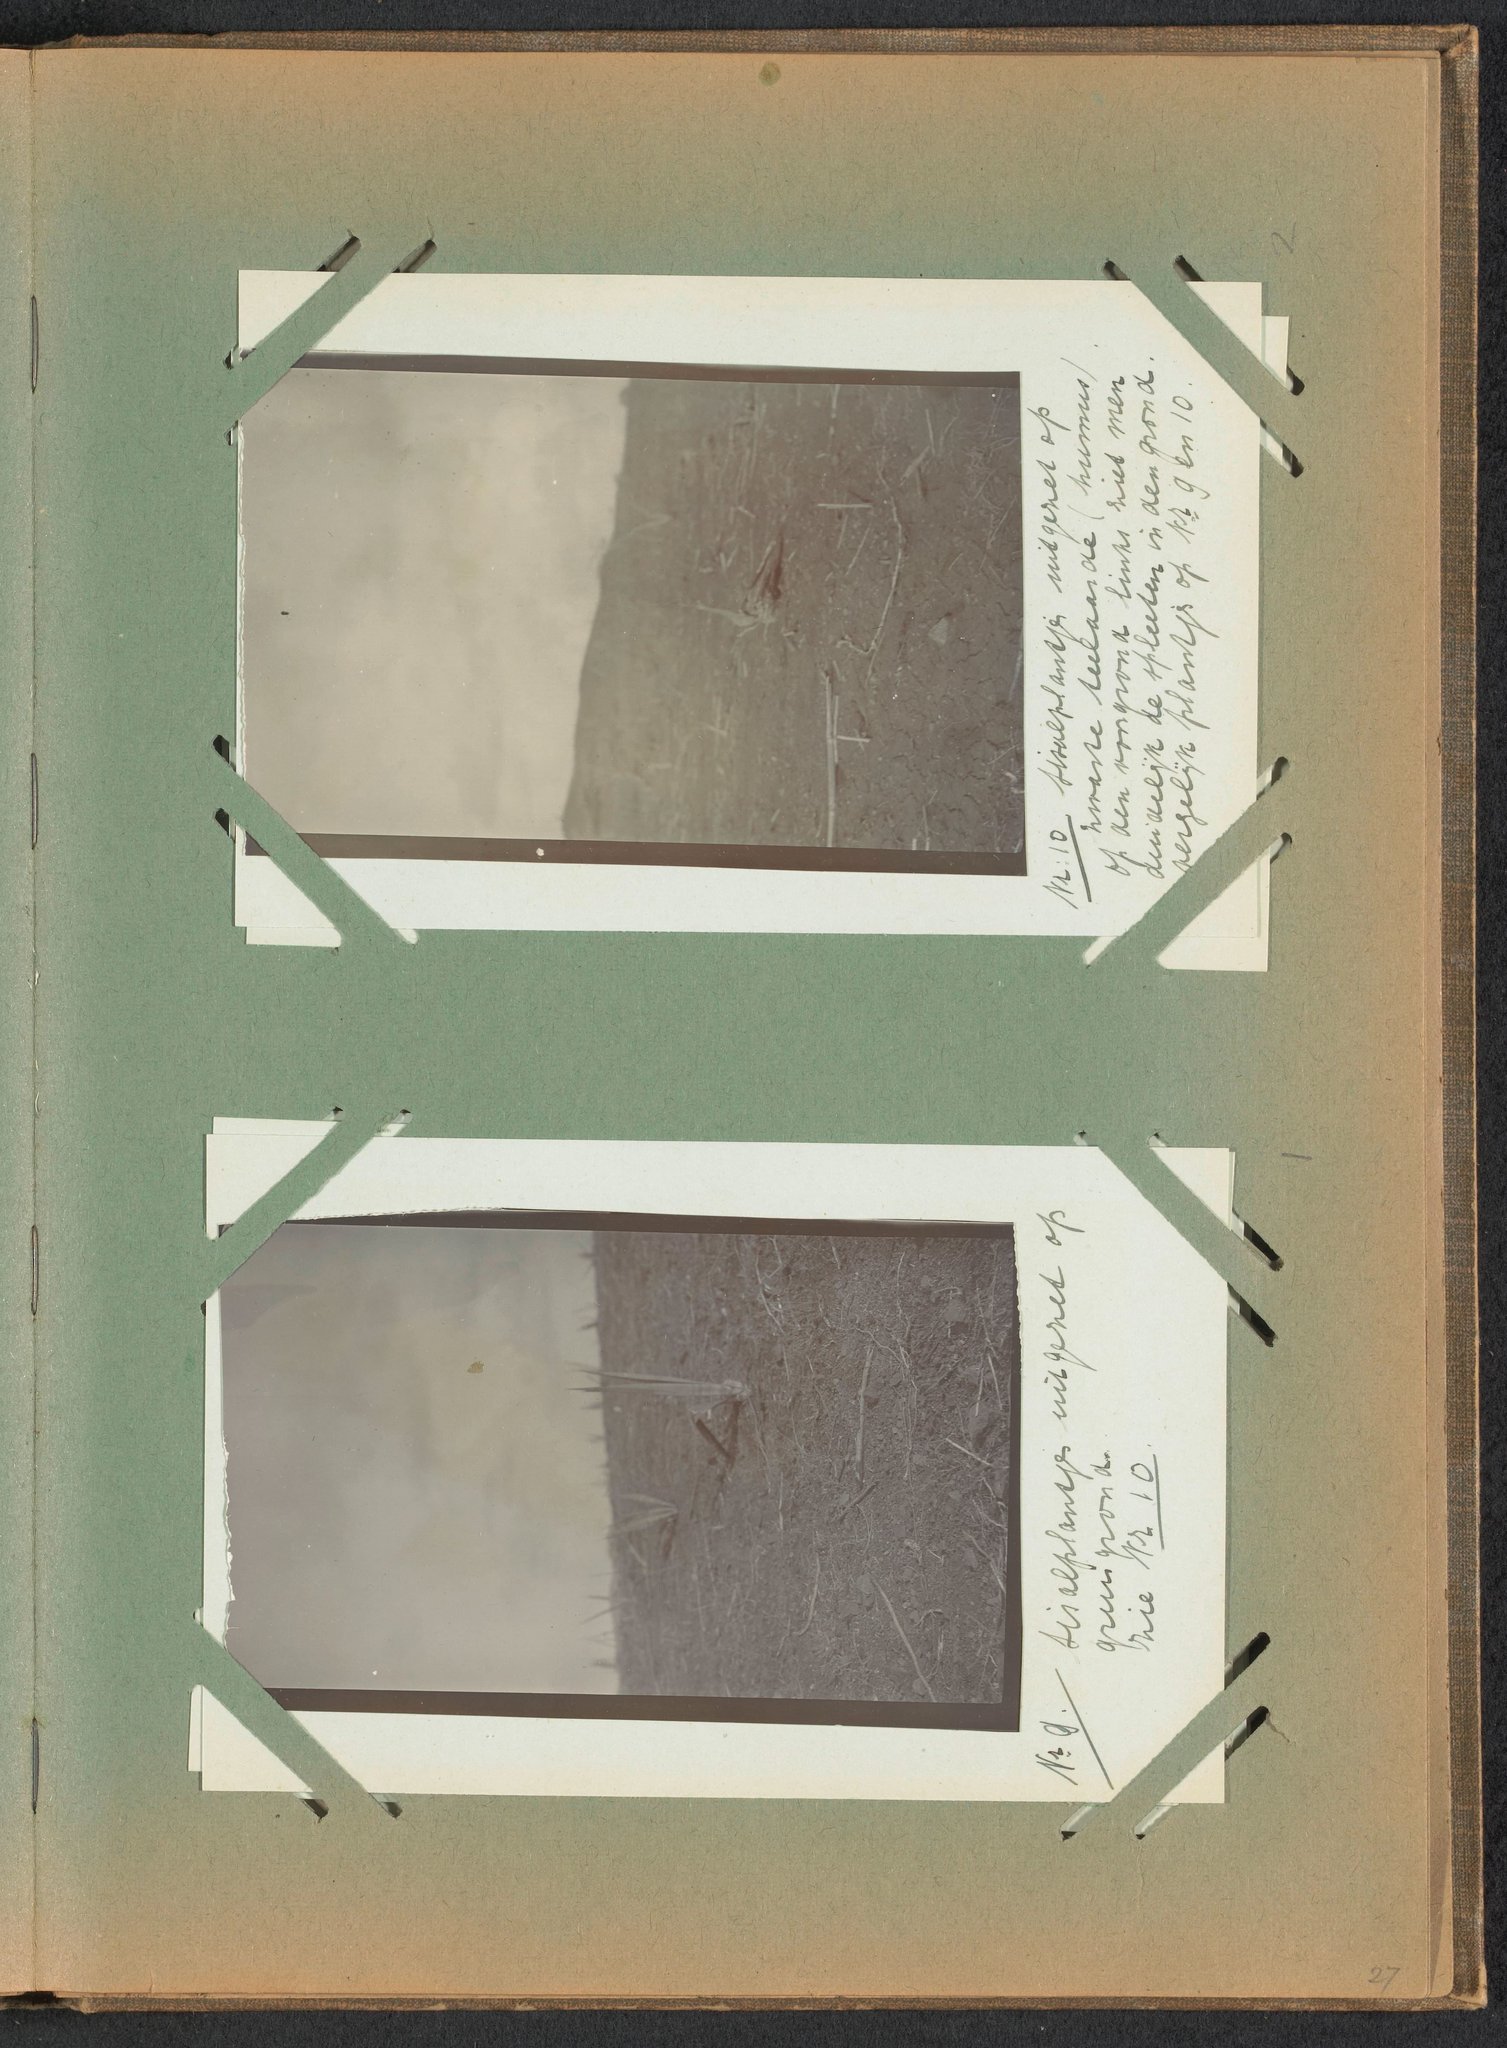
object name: photograph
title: Aanplant van sisal op Plantage Mount Pleasant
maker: Anonymous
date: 1912-1913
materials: paper, photographic support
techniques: gelatin silver print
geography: curacao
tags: plantation, (non-fruit) products of plants or trees: sisal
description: Aanplant van sisal op Plantage Mount Pleasant op Curaçao. Onderdeel van het fotoalbum uit ca. 1912-1913 met 92 foto's van de plantages Peperpot en Dordrecht in Suriname en Mount Pleasant op Curaçao.